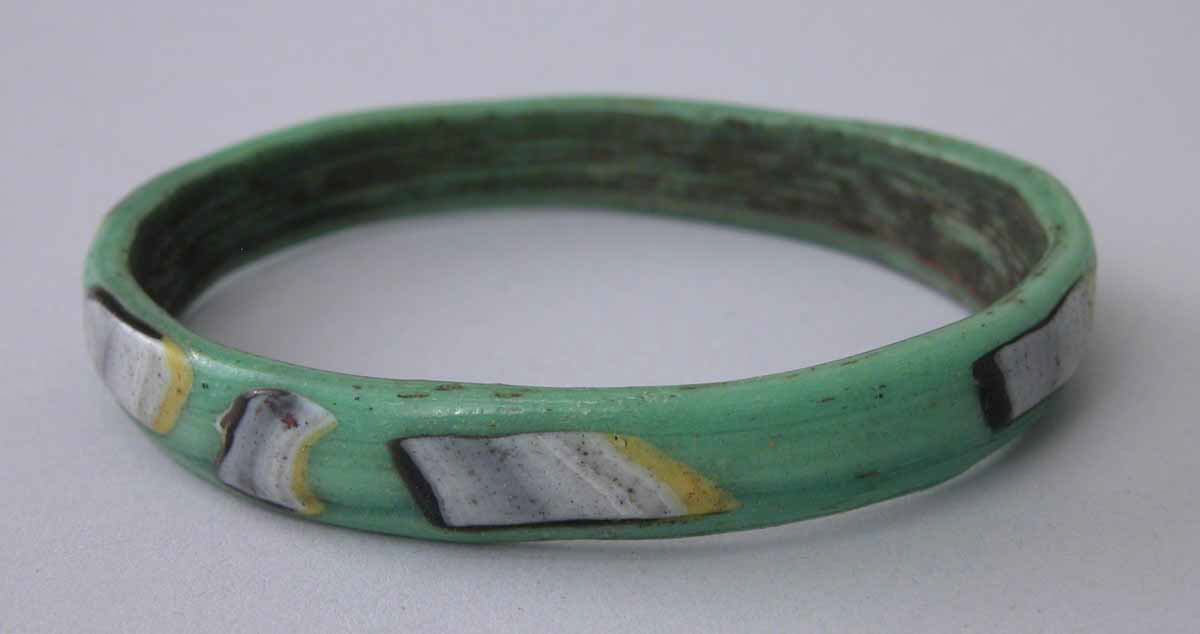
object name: bracelet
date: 1301-1500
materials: glass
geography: egypt or syria